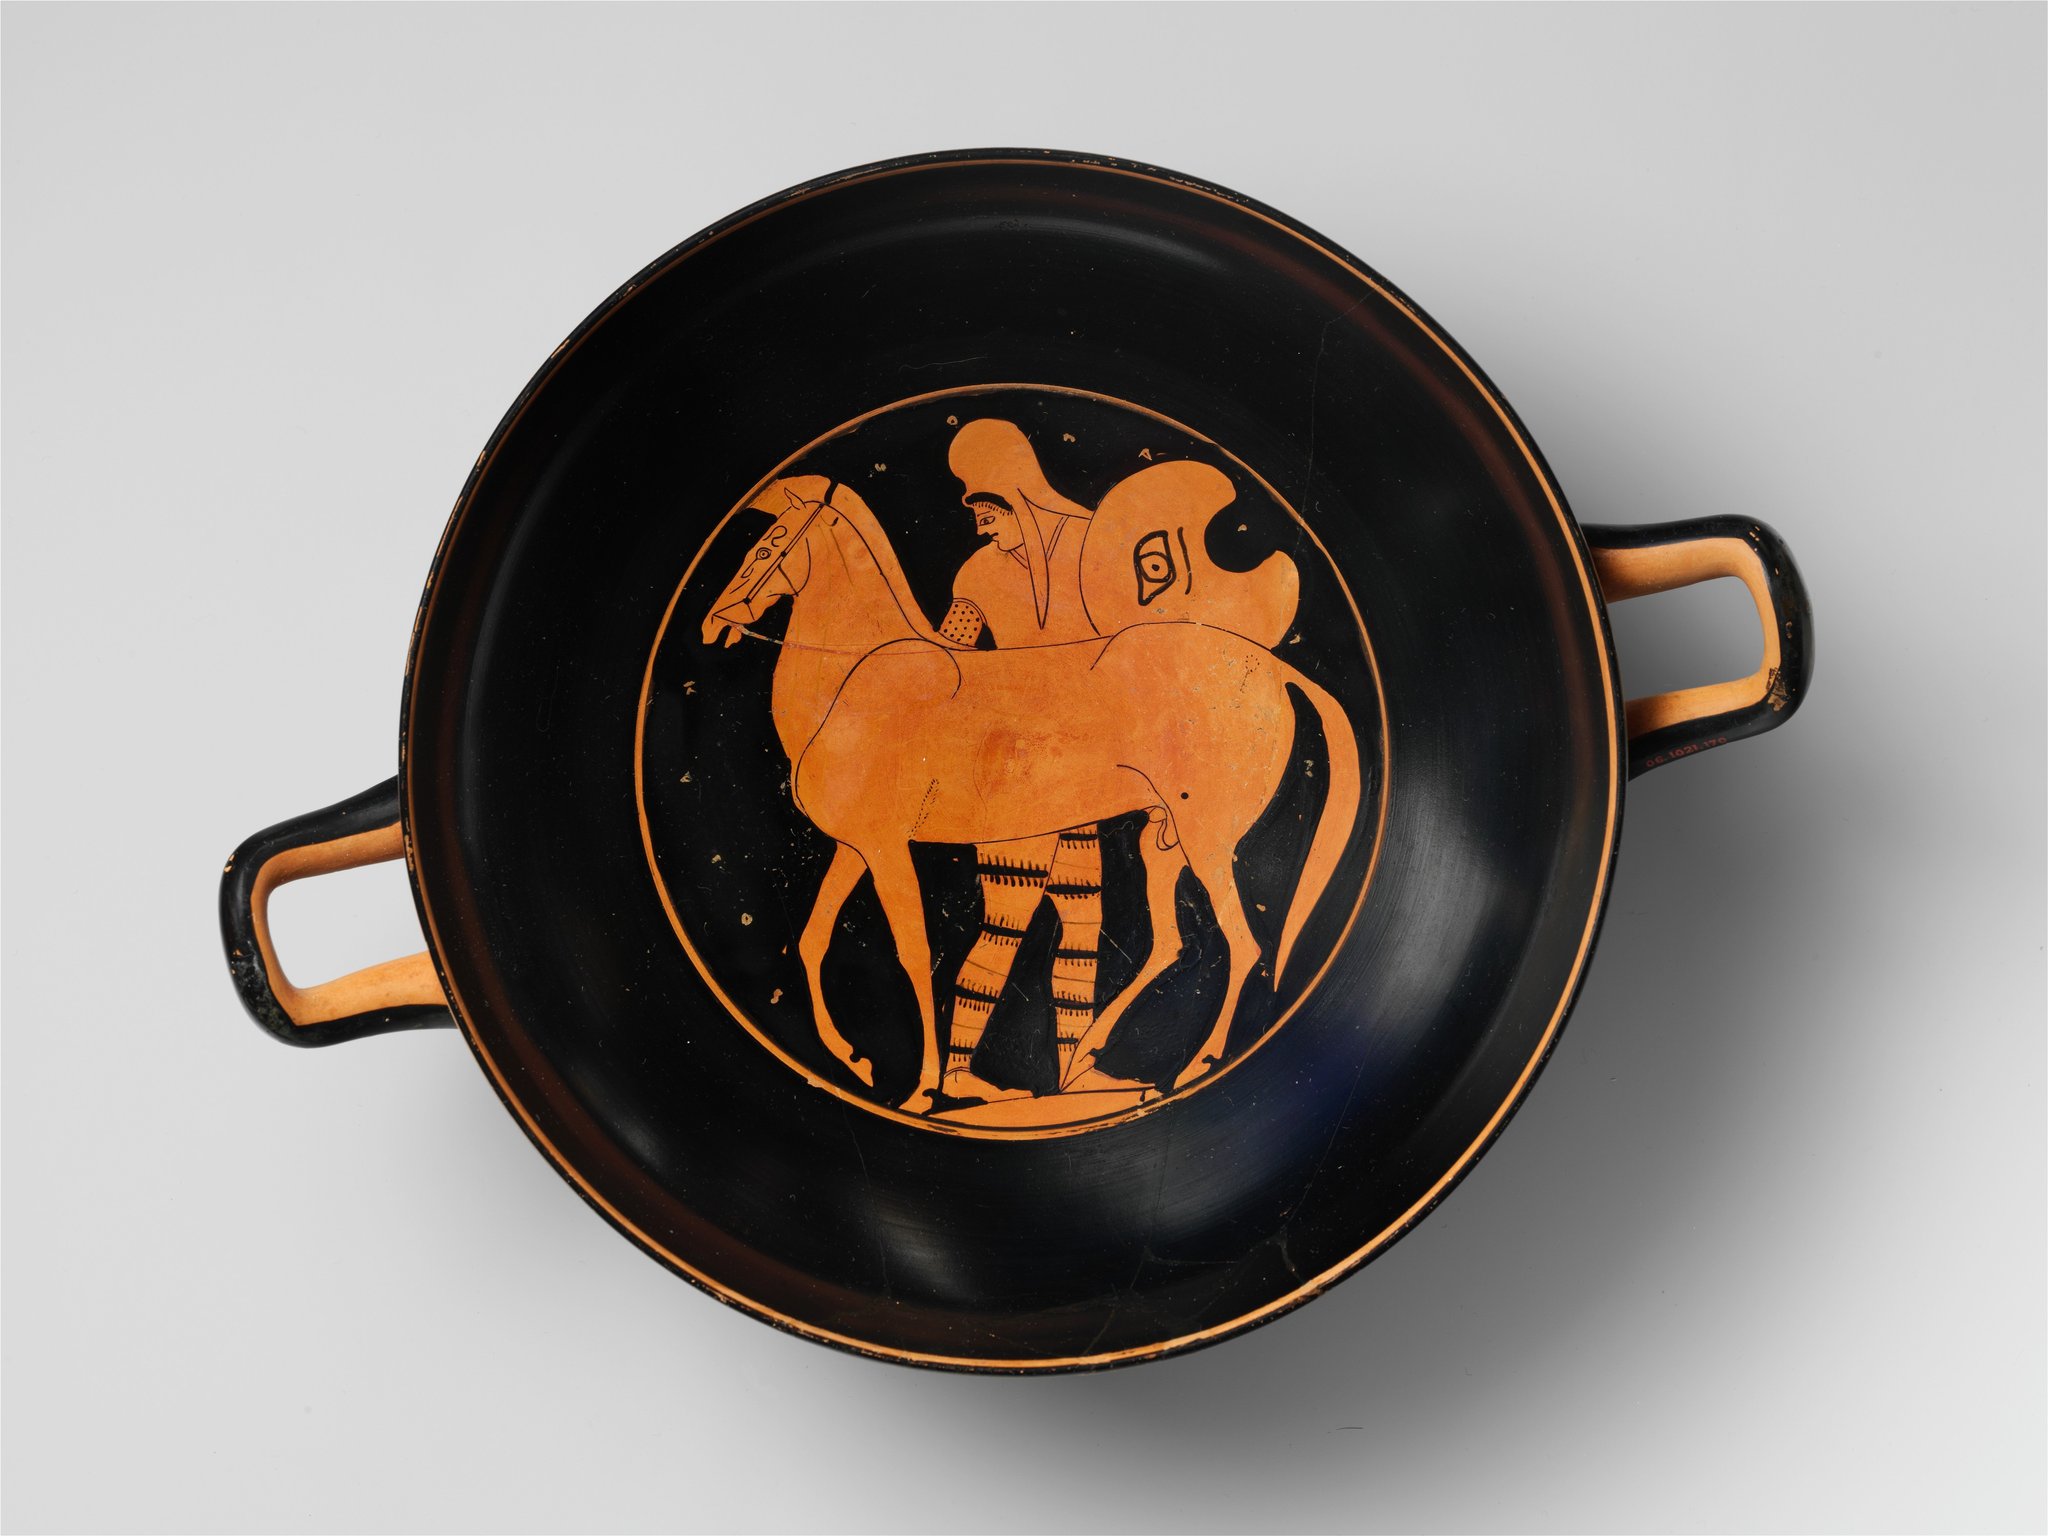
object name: kylix, type b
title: Terracotta kylix (drinking cup) with horses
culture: greek, attic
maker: painter of berlin 2268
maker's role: artist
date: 510-500 BCE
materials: terracotta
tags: men,horses